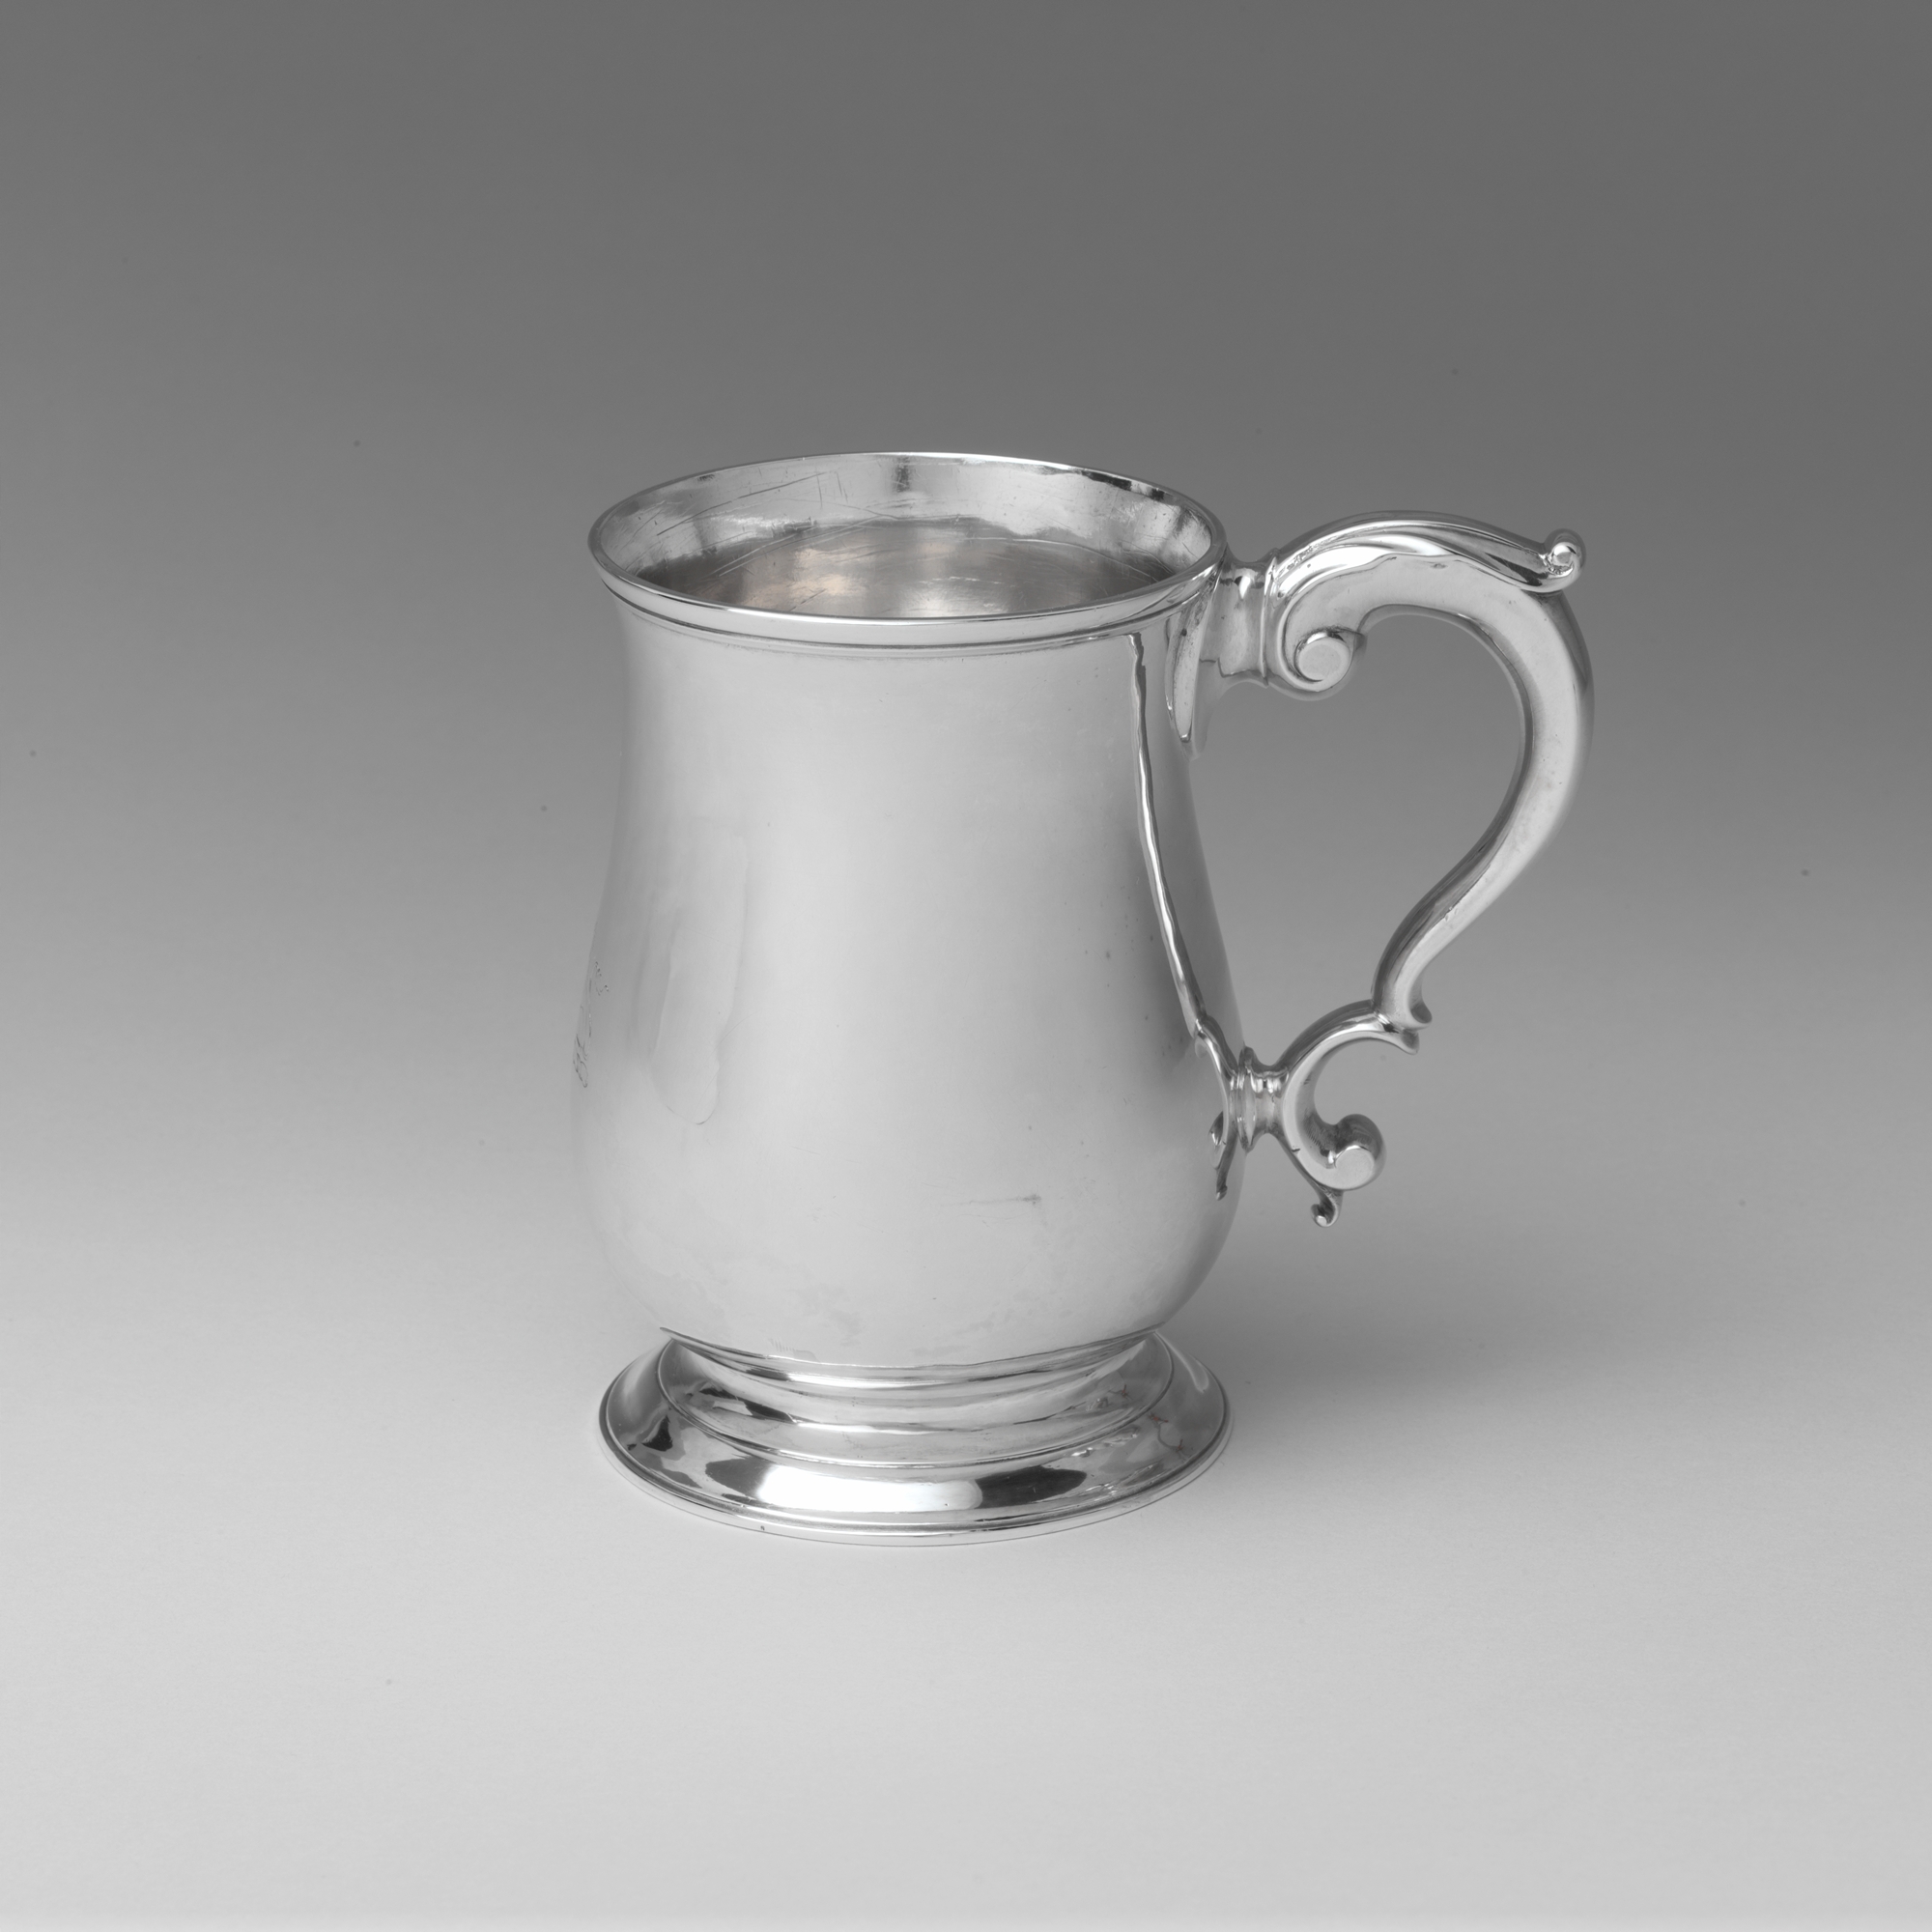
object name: cann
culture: american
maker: myer myers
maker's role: maker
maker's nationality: american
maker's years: 1723-1795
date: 1765-1776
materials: silver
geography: united states